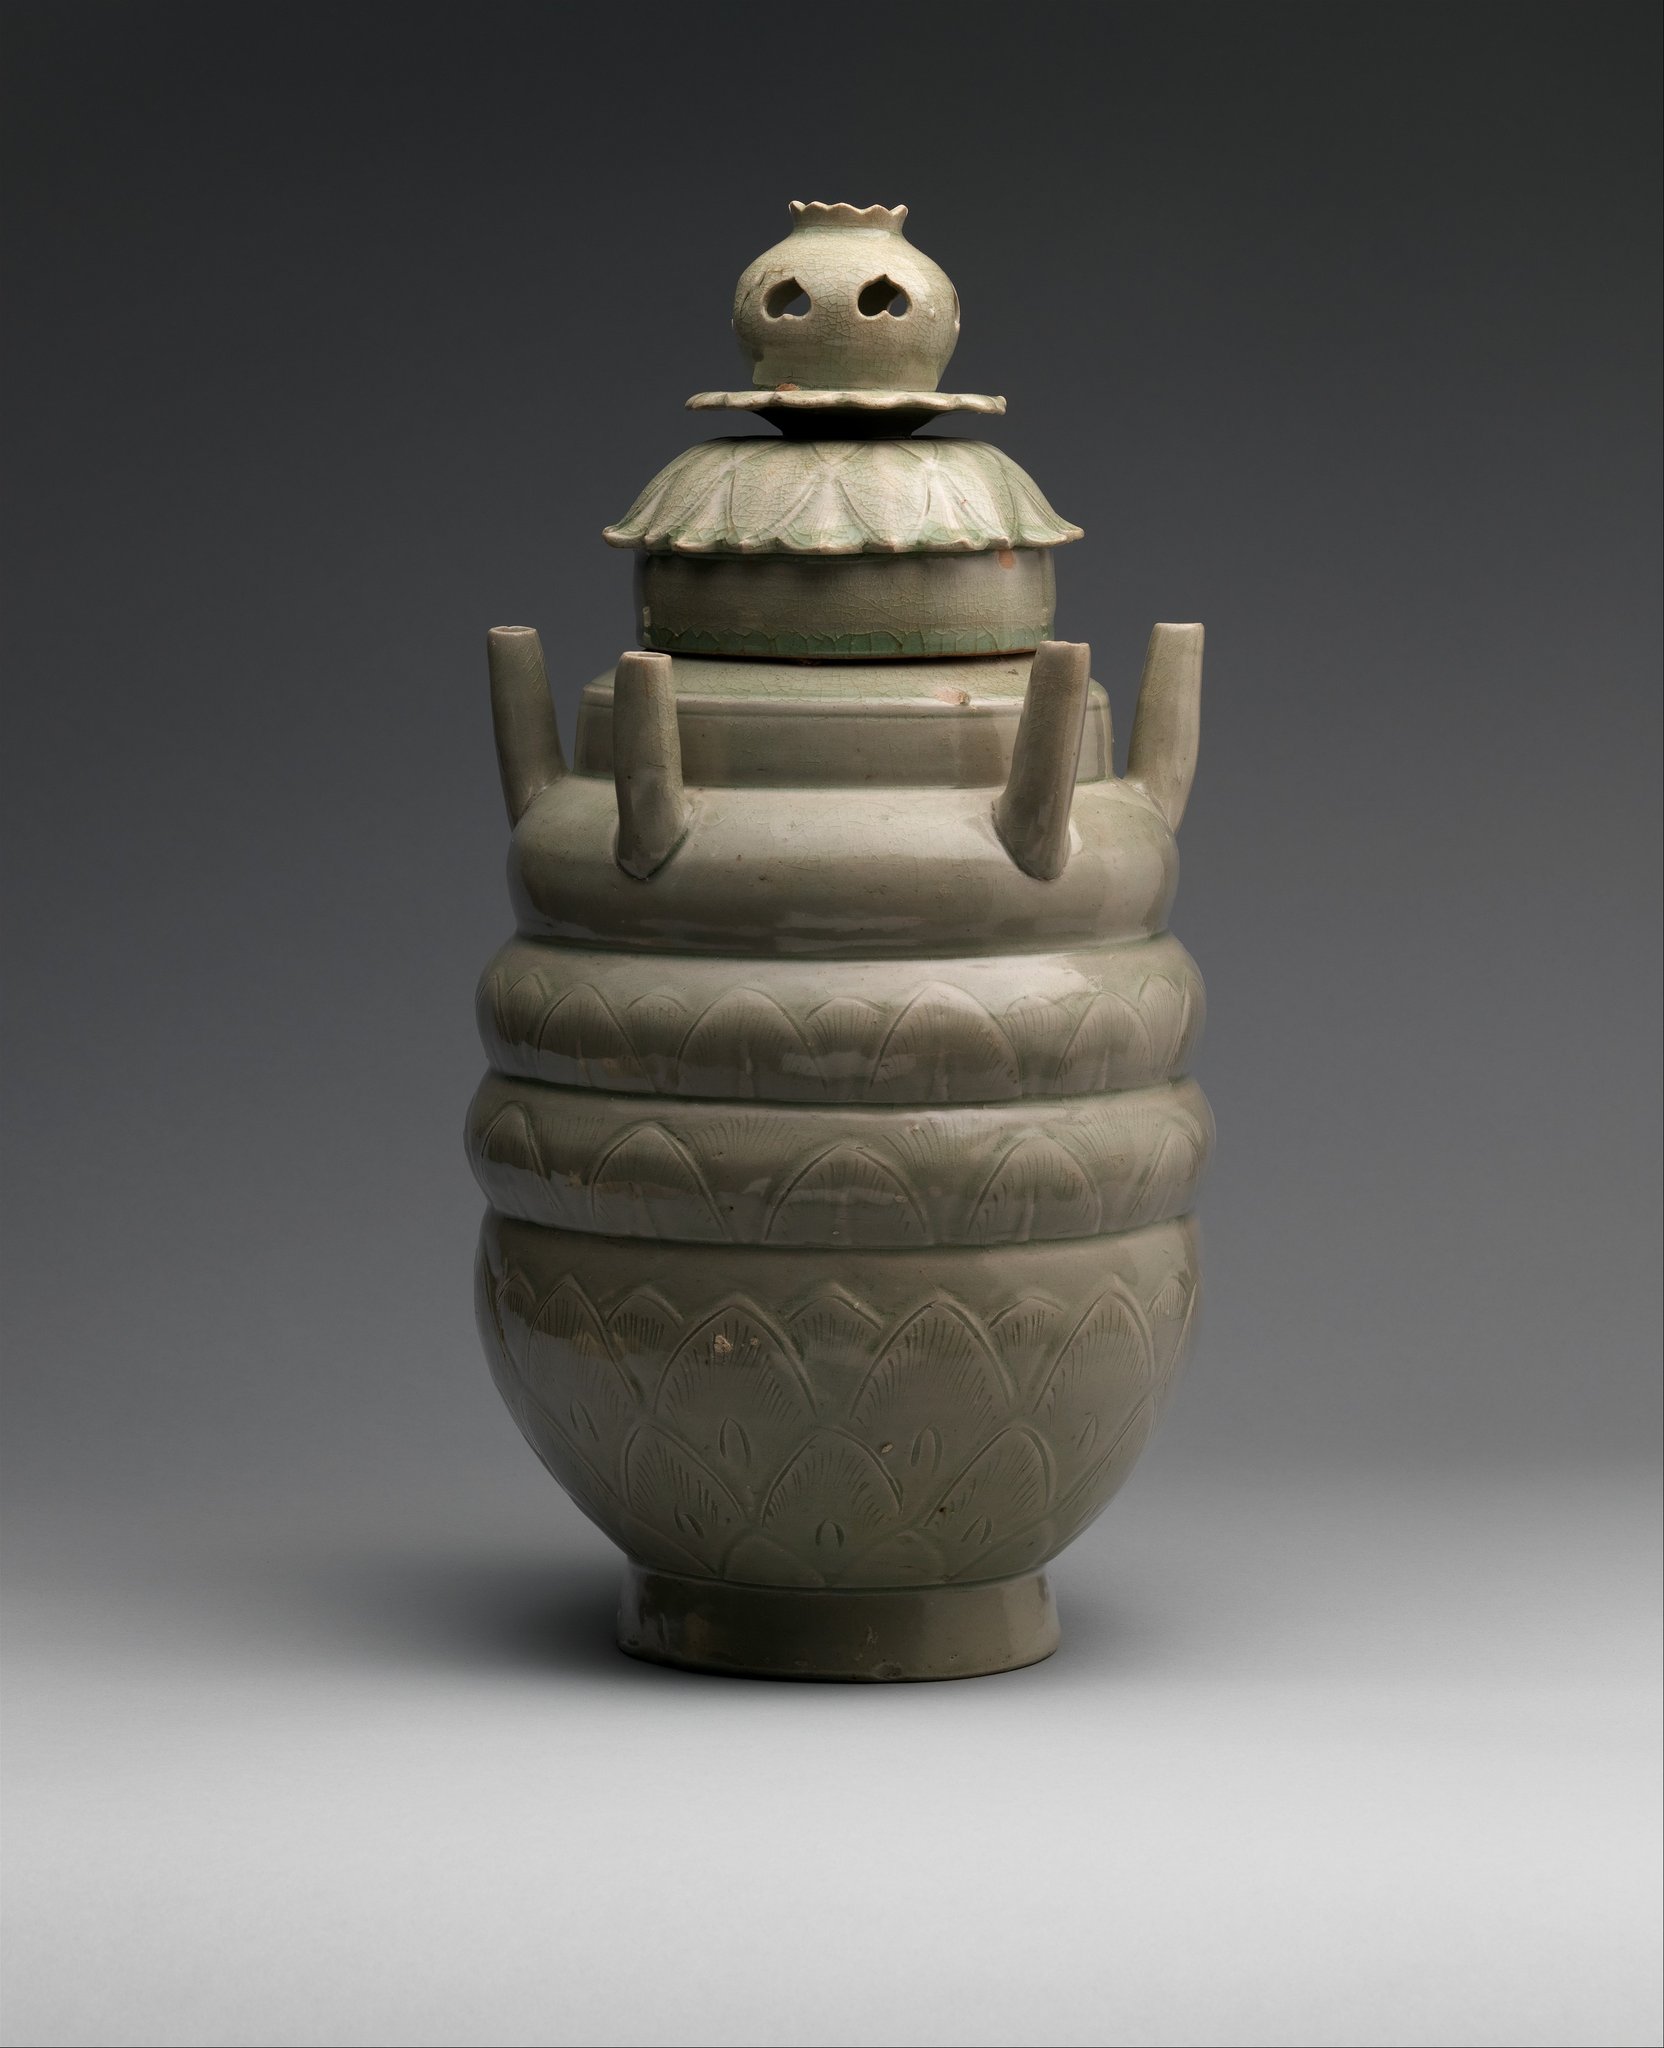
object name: urn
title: Funerary jar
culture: chinese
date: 901-1100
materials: ceramic glaze, glaze, stoneware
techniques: carving, incising